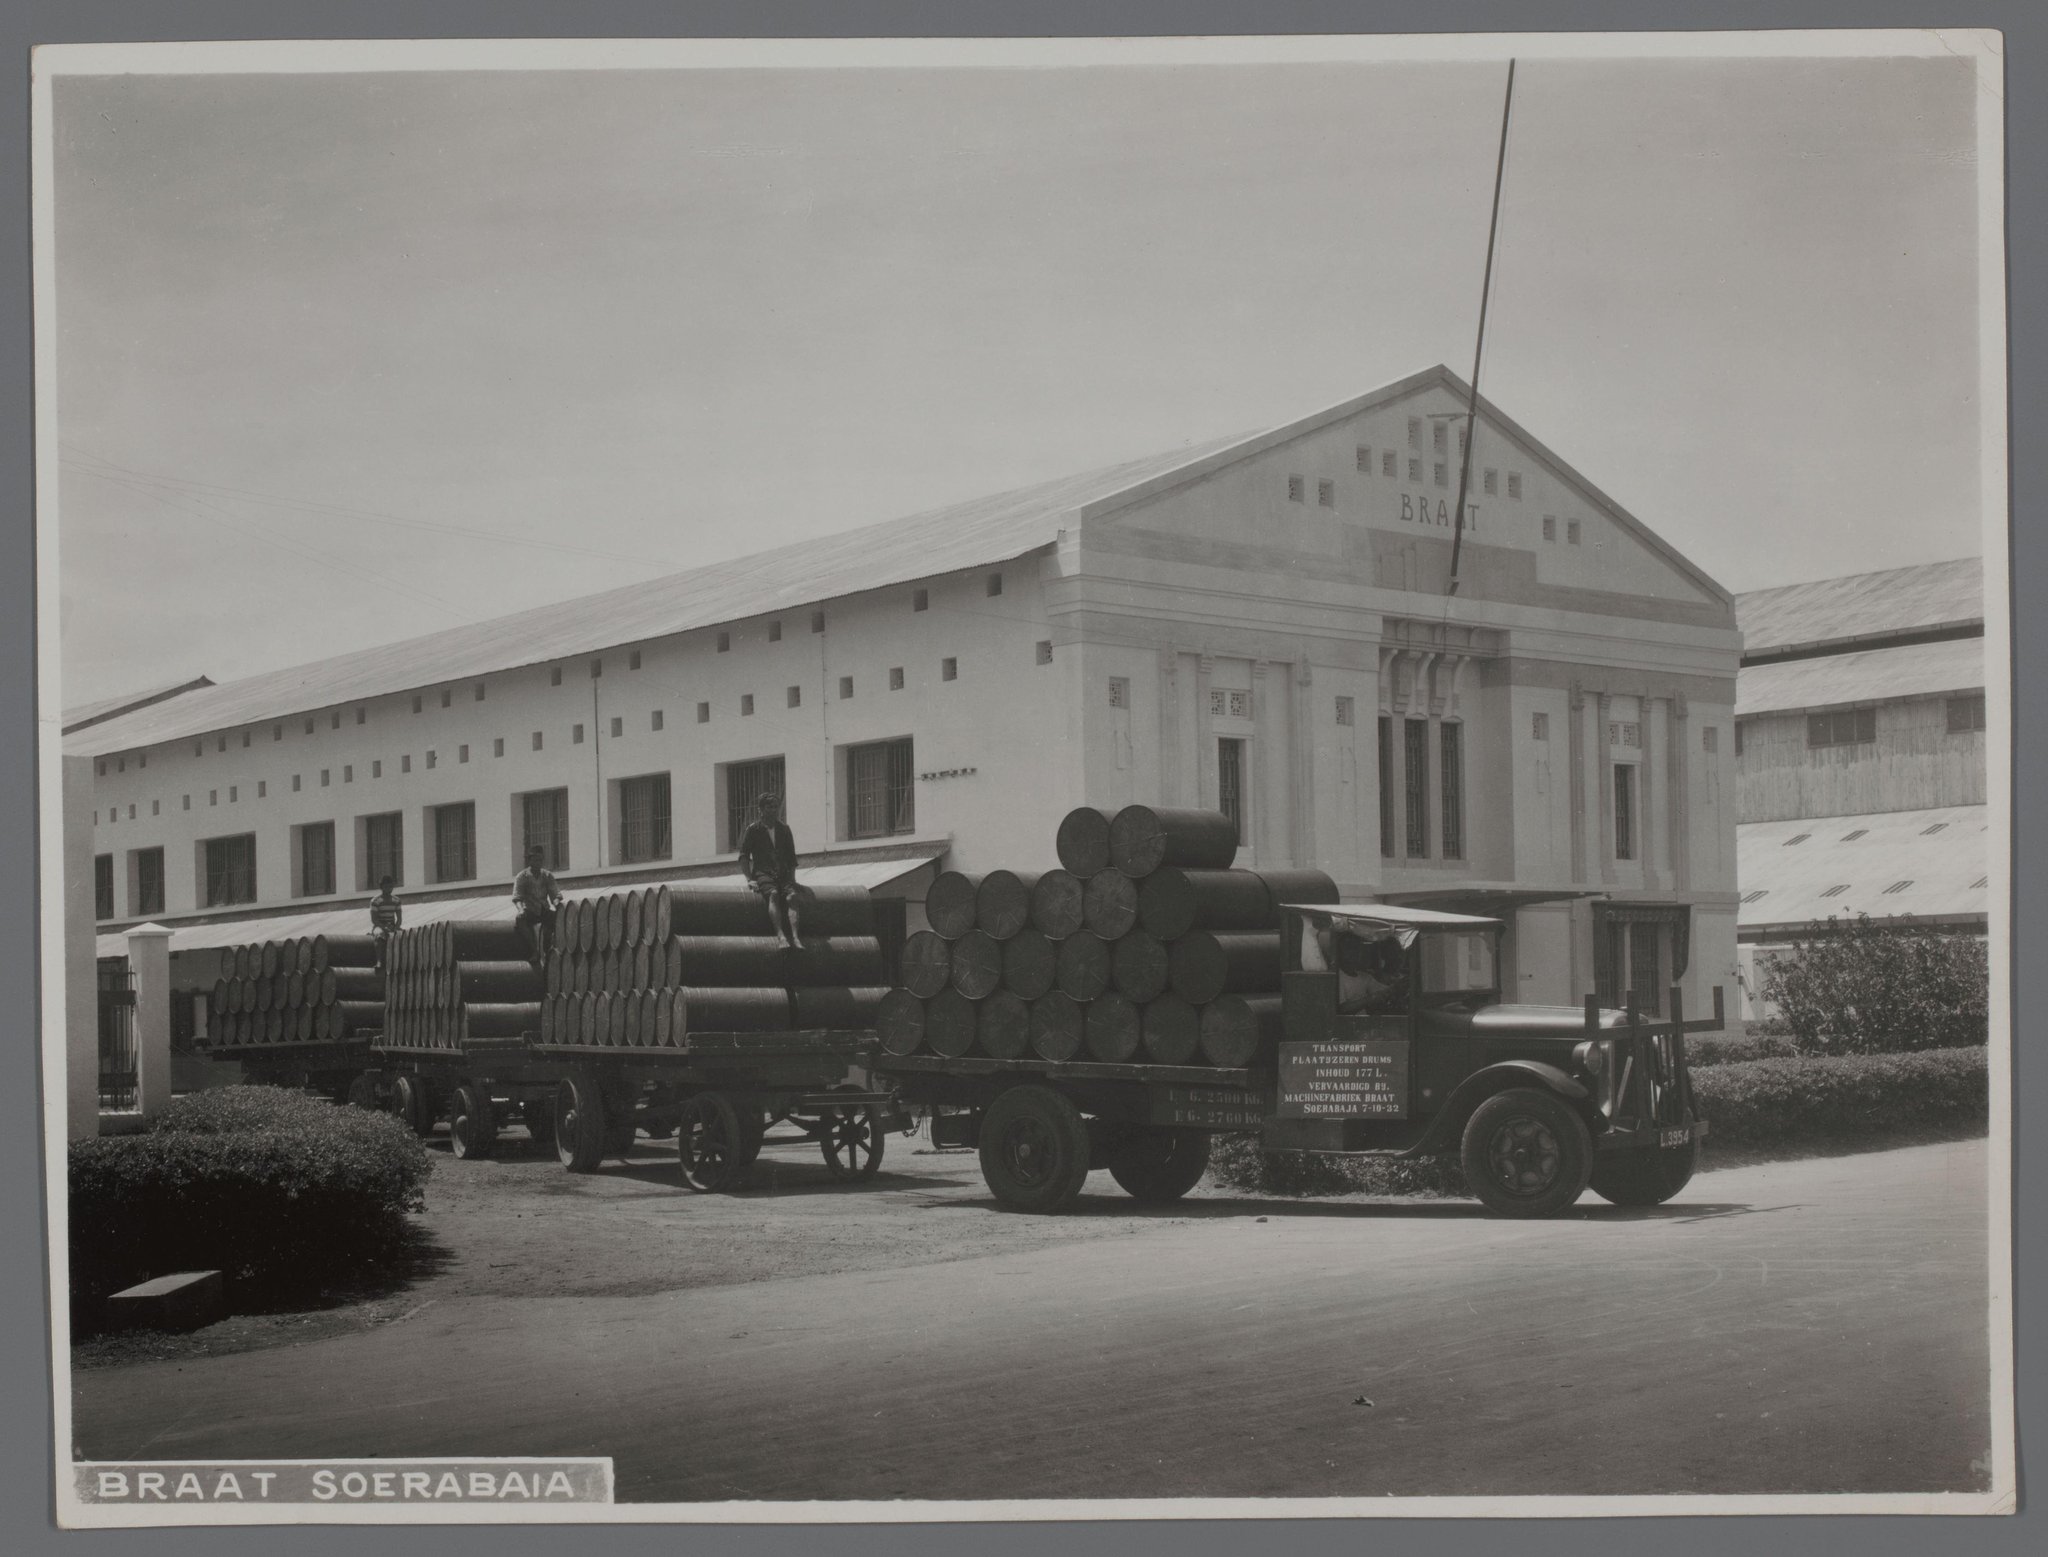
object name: photograph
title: Transport van plaatijzeren drums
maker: Anonymous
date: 1932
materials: photographic support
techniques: gelatin silver print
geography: surabaya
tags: truck, van, colonial system, machines; parts of machines; tools and appliances, java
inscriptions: date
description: Transport van een lading plaatijzeren drums op een vrachtwagen met opleggers. Vervaardigd in 1932 in Soerabaja en bestemd voor de Boeton Maatschappij. Onderdeel van de multomap met foto's van machines van de N.V. Machinefabriek Braat te Soerabaja, Soekaboemi en Jogyakarta, uit de periode 1908-1942.